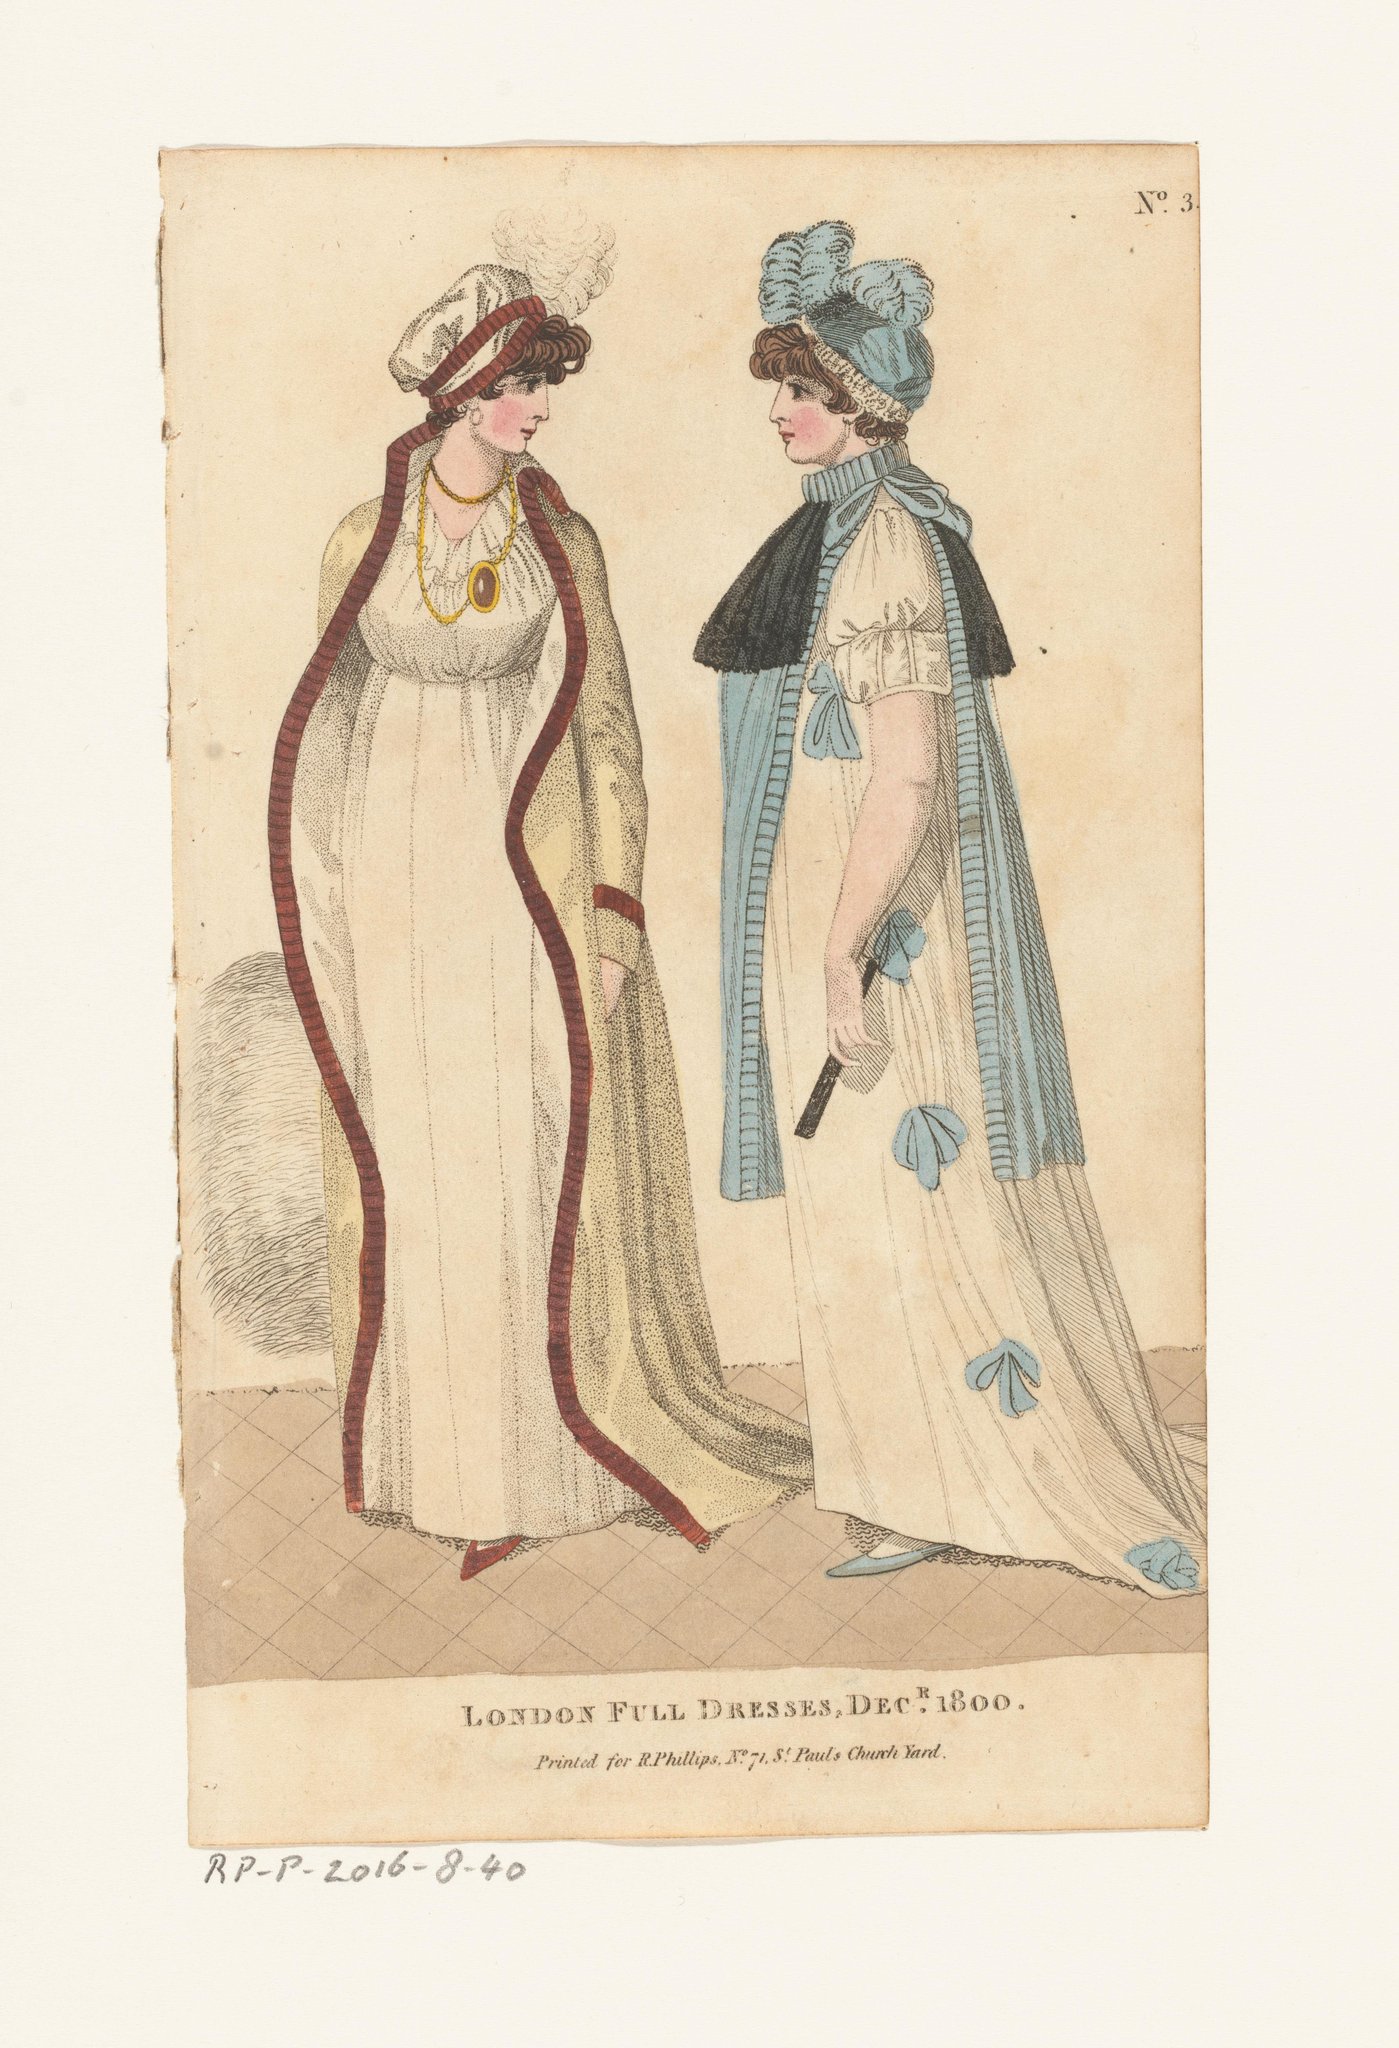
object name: fashion print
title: Magazine of Female Fashions of London and Paris, London Full Dresses, Dec. 1800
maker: richard phillips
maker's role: bookseller, publisher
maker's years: 1767-1840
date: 1800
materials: paper, ink, watercolor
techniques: etching, hand coloring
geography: london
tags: fashion plates, head-gear: hat (+ women's clothes), dress, gown (+ women's clothes), fan (+ women's clothes)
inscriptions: collector's mark: Lugt 2228, : ‘London Full Dresses, Dec. 1800’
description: Twee vrouwen in 'London full dresses', 1800.